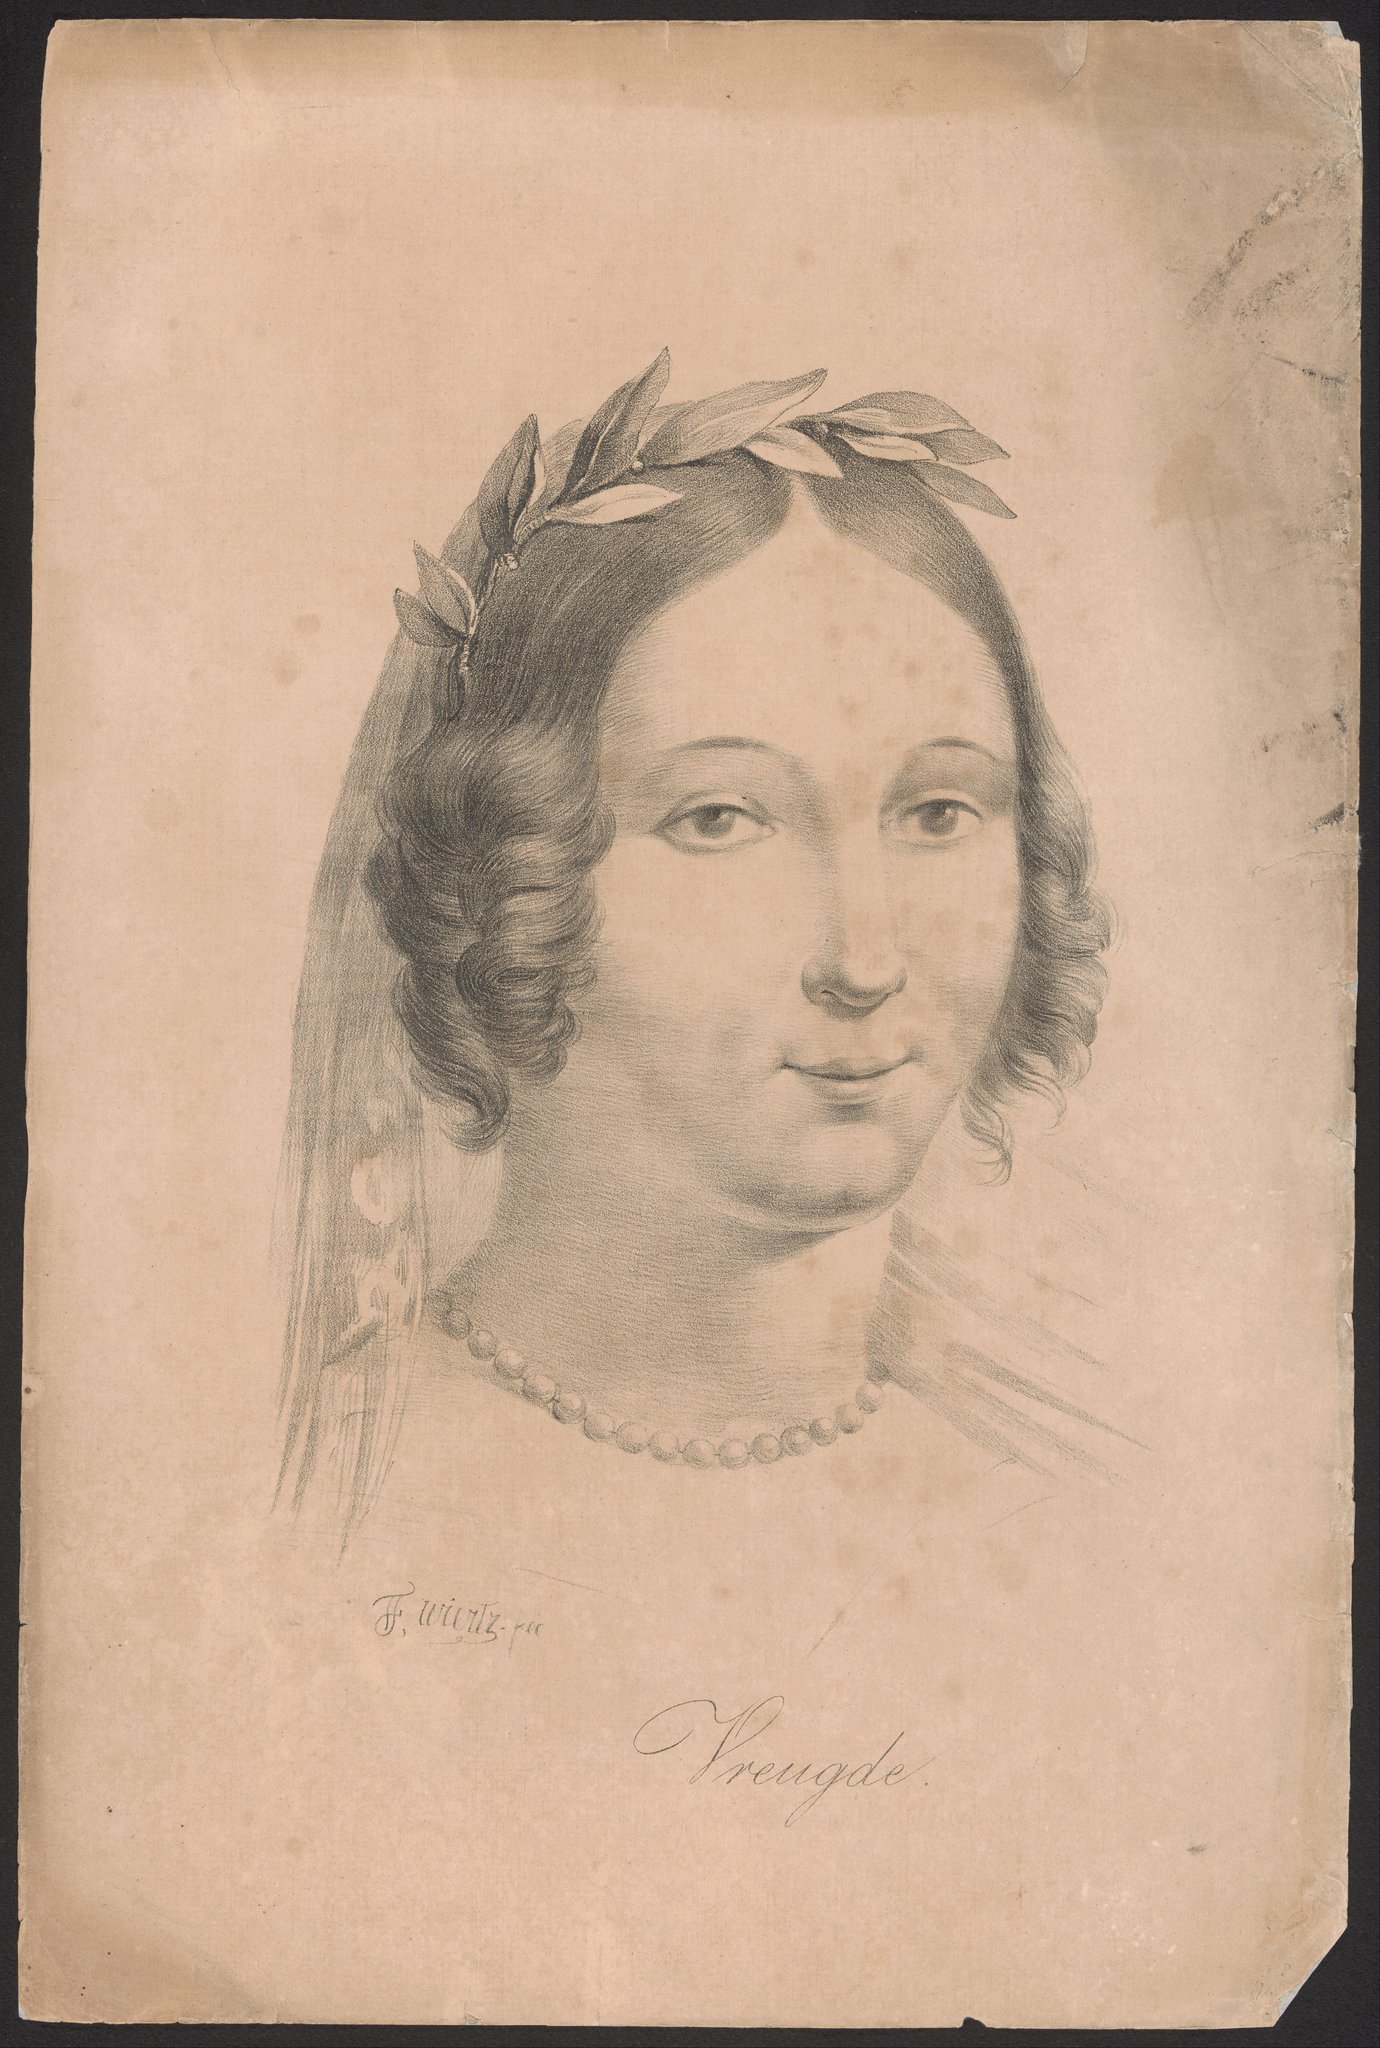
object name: print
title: Vreugde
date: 1847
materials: paper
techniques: lithograph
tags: historical persons (+ head (and shoulders) (portrait)), passions, emotions, affections, happiness, felicity, veil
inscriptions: collector's mark: Lugt 2228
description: De vrouw glimlacht. Ze draagt een sluier en een krans van laurierbladeren. Maakt deel uit van een omslag met een tekstblad en twaalf prenten.